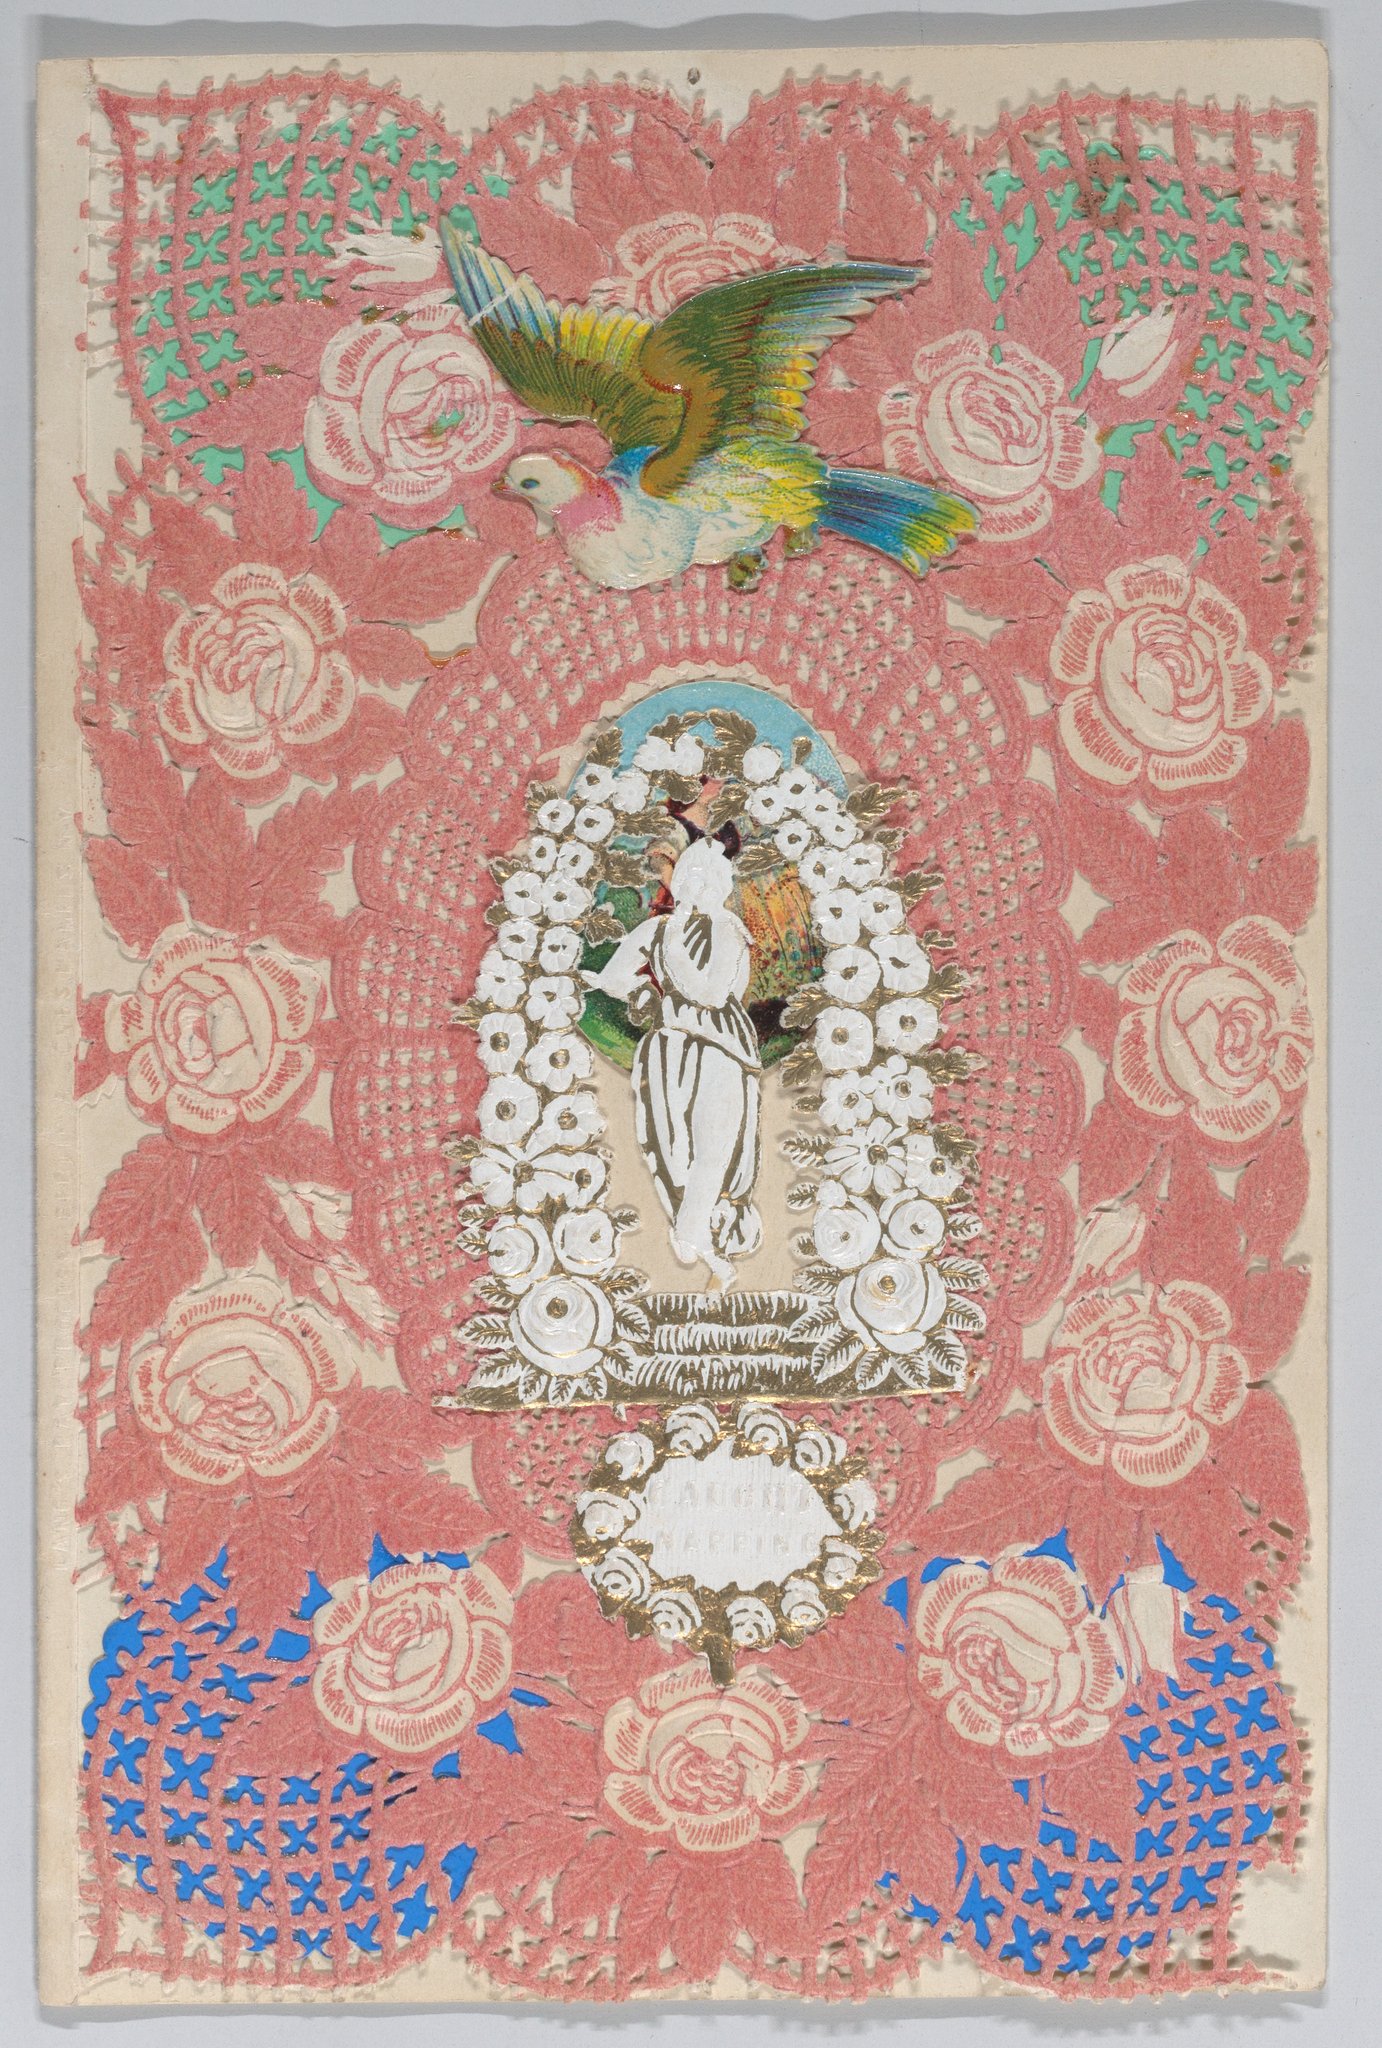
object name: valentine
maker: Anonymous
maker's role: artist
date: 1850-1879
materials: graphite, ink, lace, paper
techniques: chromolithography, cutting, embossing, open work